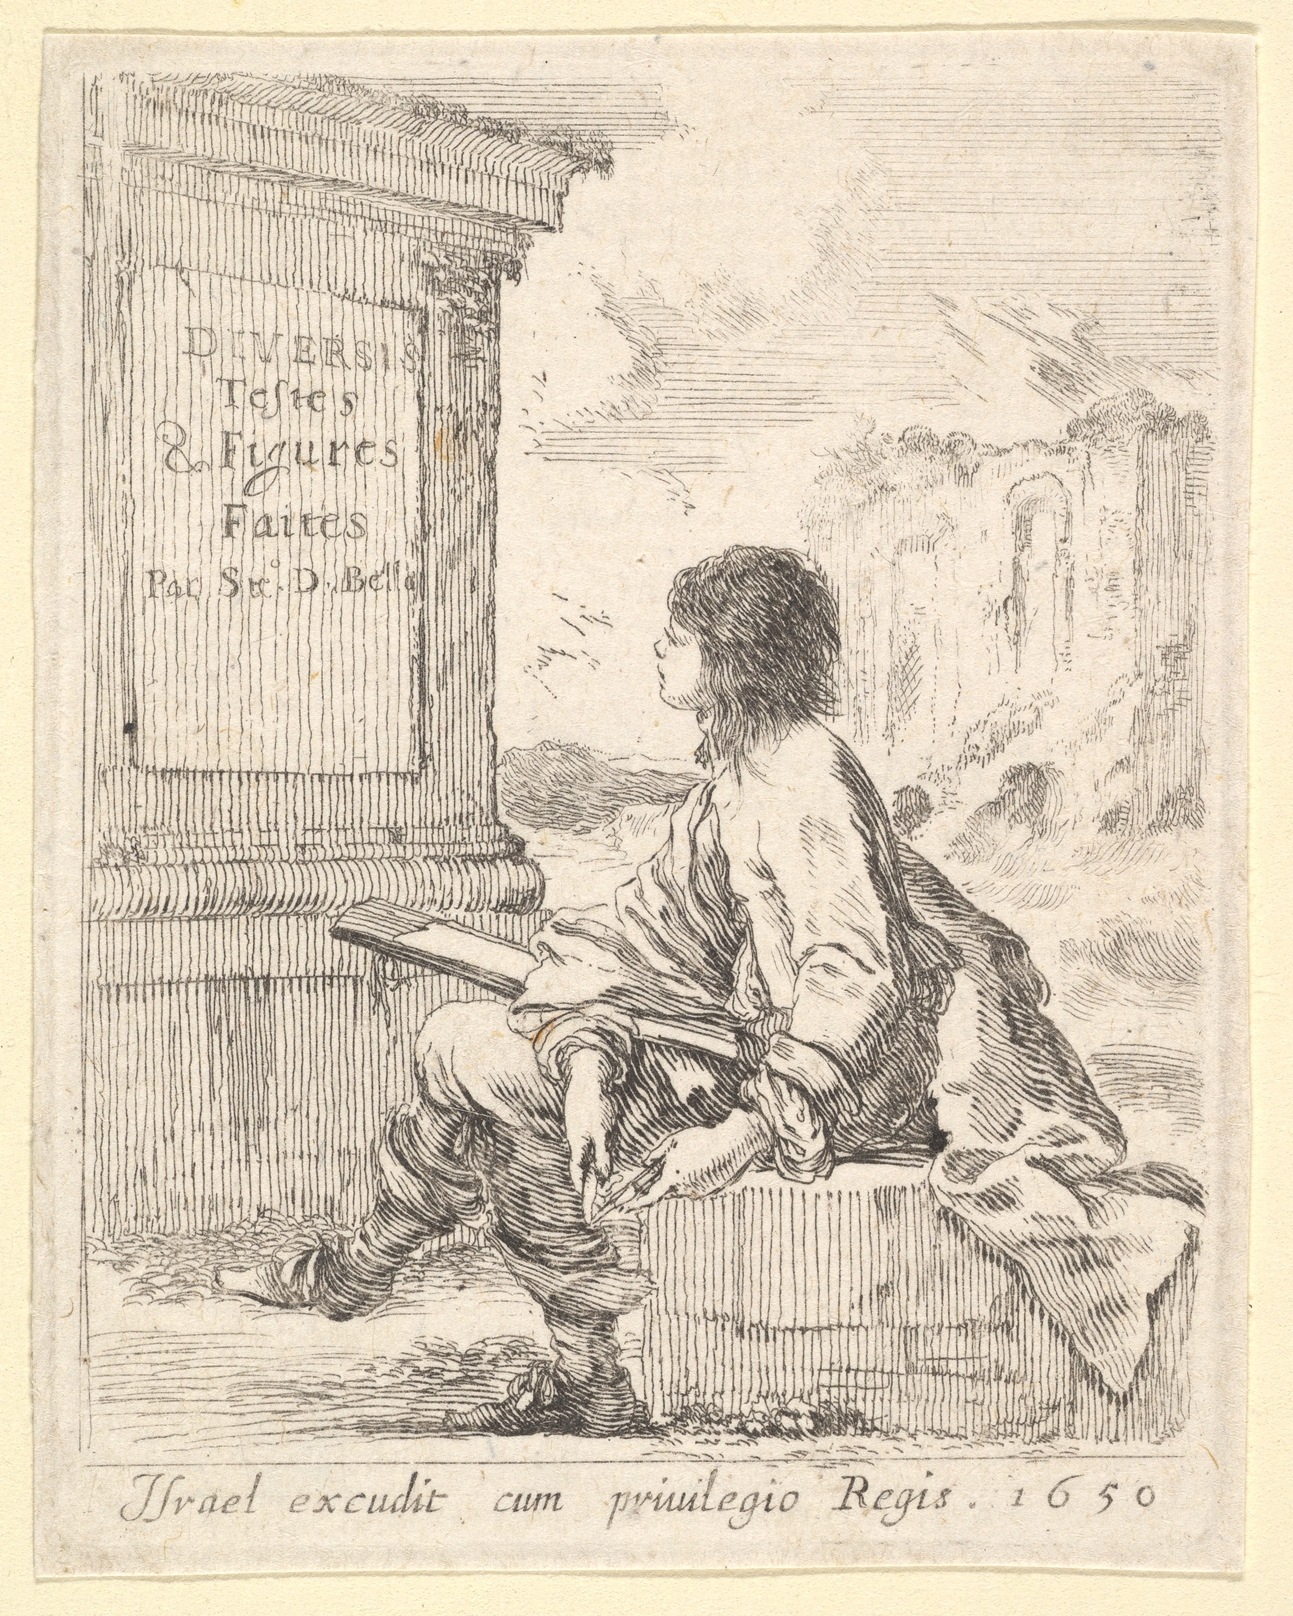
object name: print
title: Plate 1: a young man sitting on a stone, facing left in profile, holding a drawing pad in his lap and a pen in his left hand, a pedestal with title to left and ruins to right in the background, title page from "Various heads and figures" (Diverses têtes et figures)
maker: stefano della bella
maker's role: artist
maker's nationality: italian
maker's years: 1610-1664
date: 1650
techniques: etching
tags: ruins,men,profiles